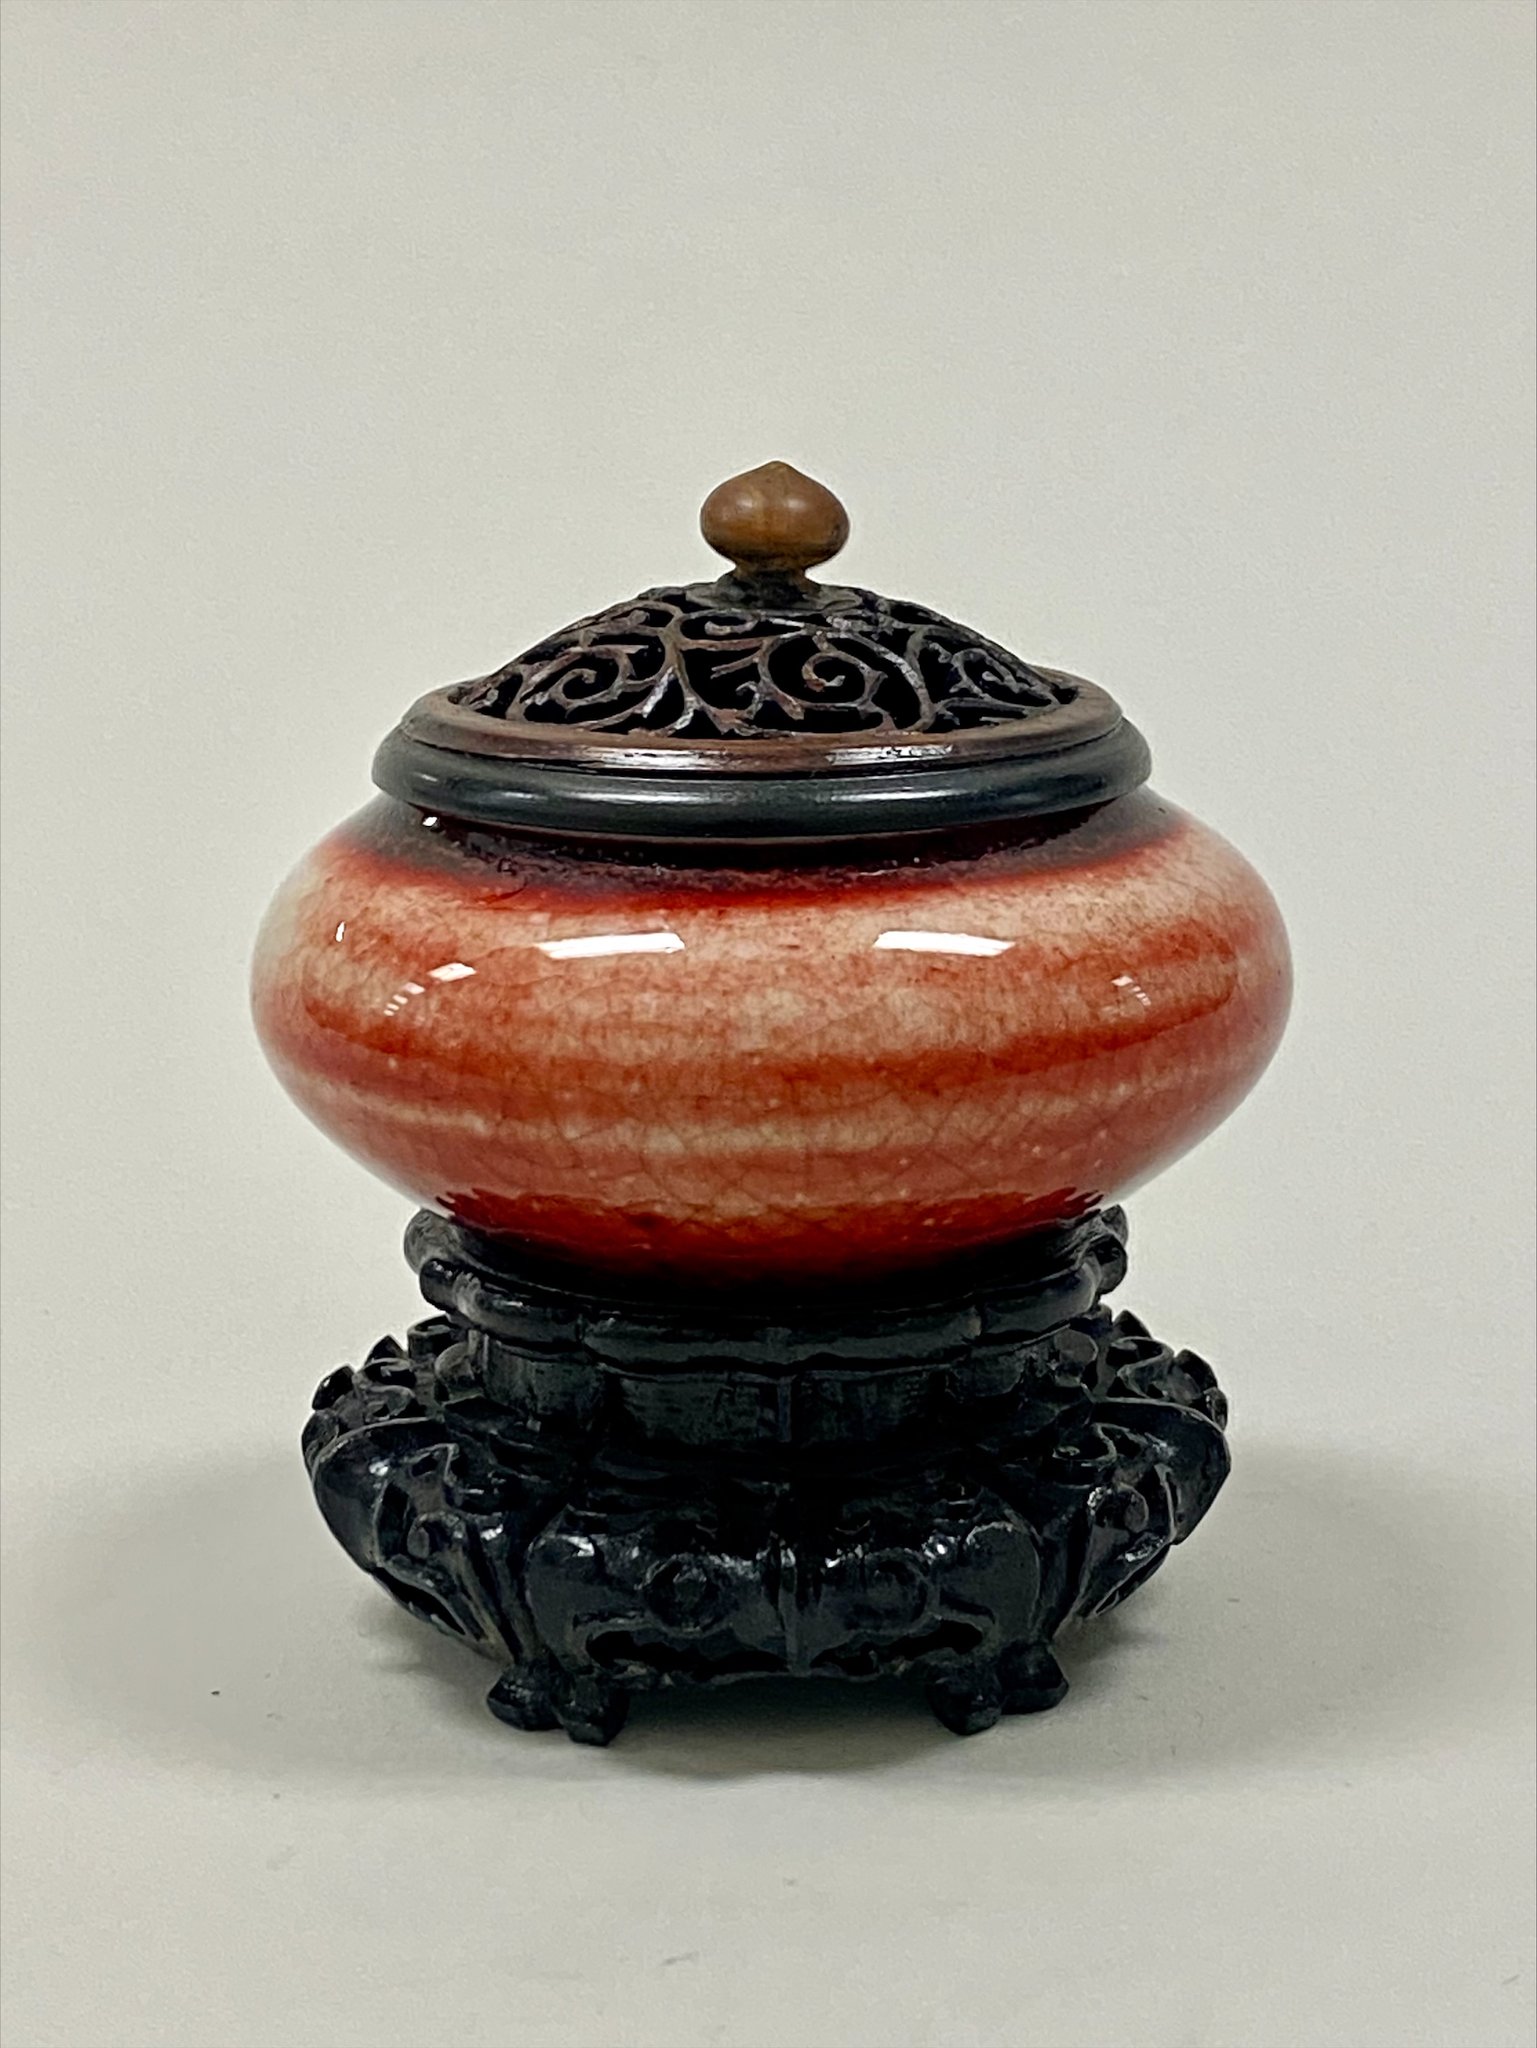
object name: water pot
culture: chinese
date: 1701-1800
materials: copper, glaze, porcelain